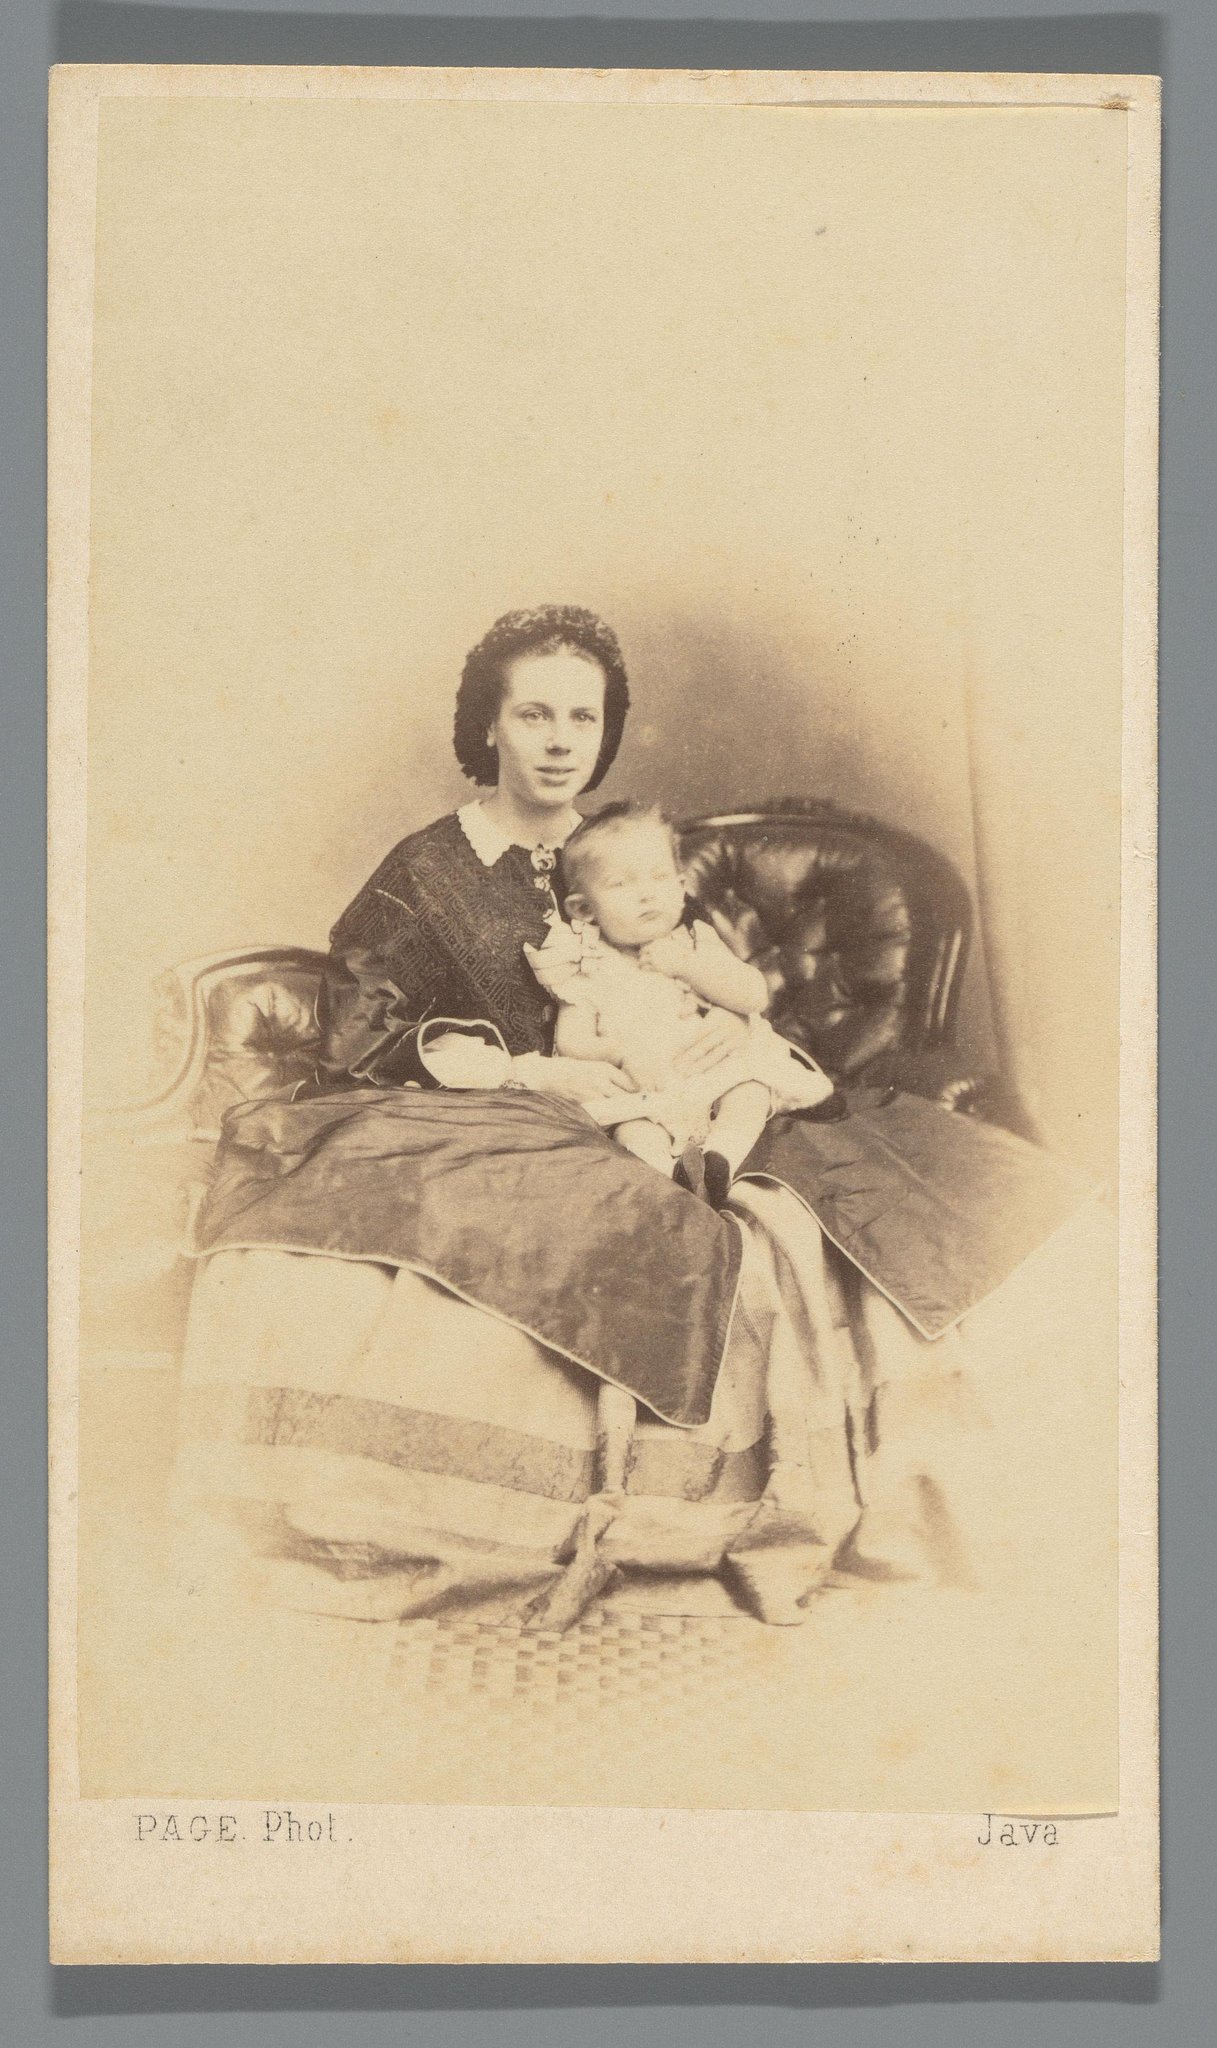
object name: photograph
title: Portret van Carolina Frederika Holle met baby (Frans A.?) op schoot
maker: james page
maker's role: fotograaf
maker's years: 1833-1865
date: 1855-1910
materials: cardboard, photographic support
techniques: albumen print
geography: java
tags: amsterdam, carolina frederika van den berg-holle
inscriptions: name: ‘PAGE Phot. Java’, name: ‘PAGE, / PHOTOGRAPHE / JAVA.’, inscription: ‘ex. Dames - Holle’, name: ‘CFvdB - Holle / Frans A ?’